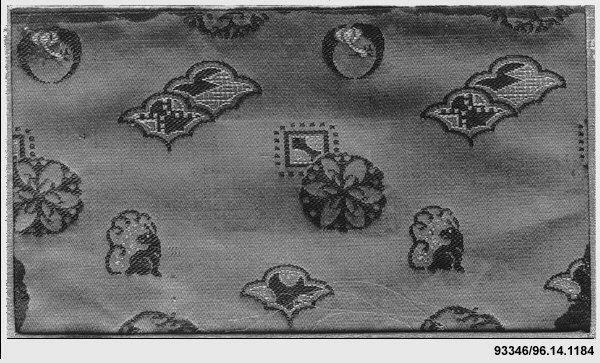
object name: piece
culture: japanese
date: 1701-1900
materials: silk